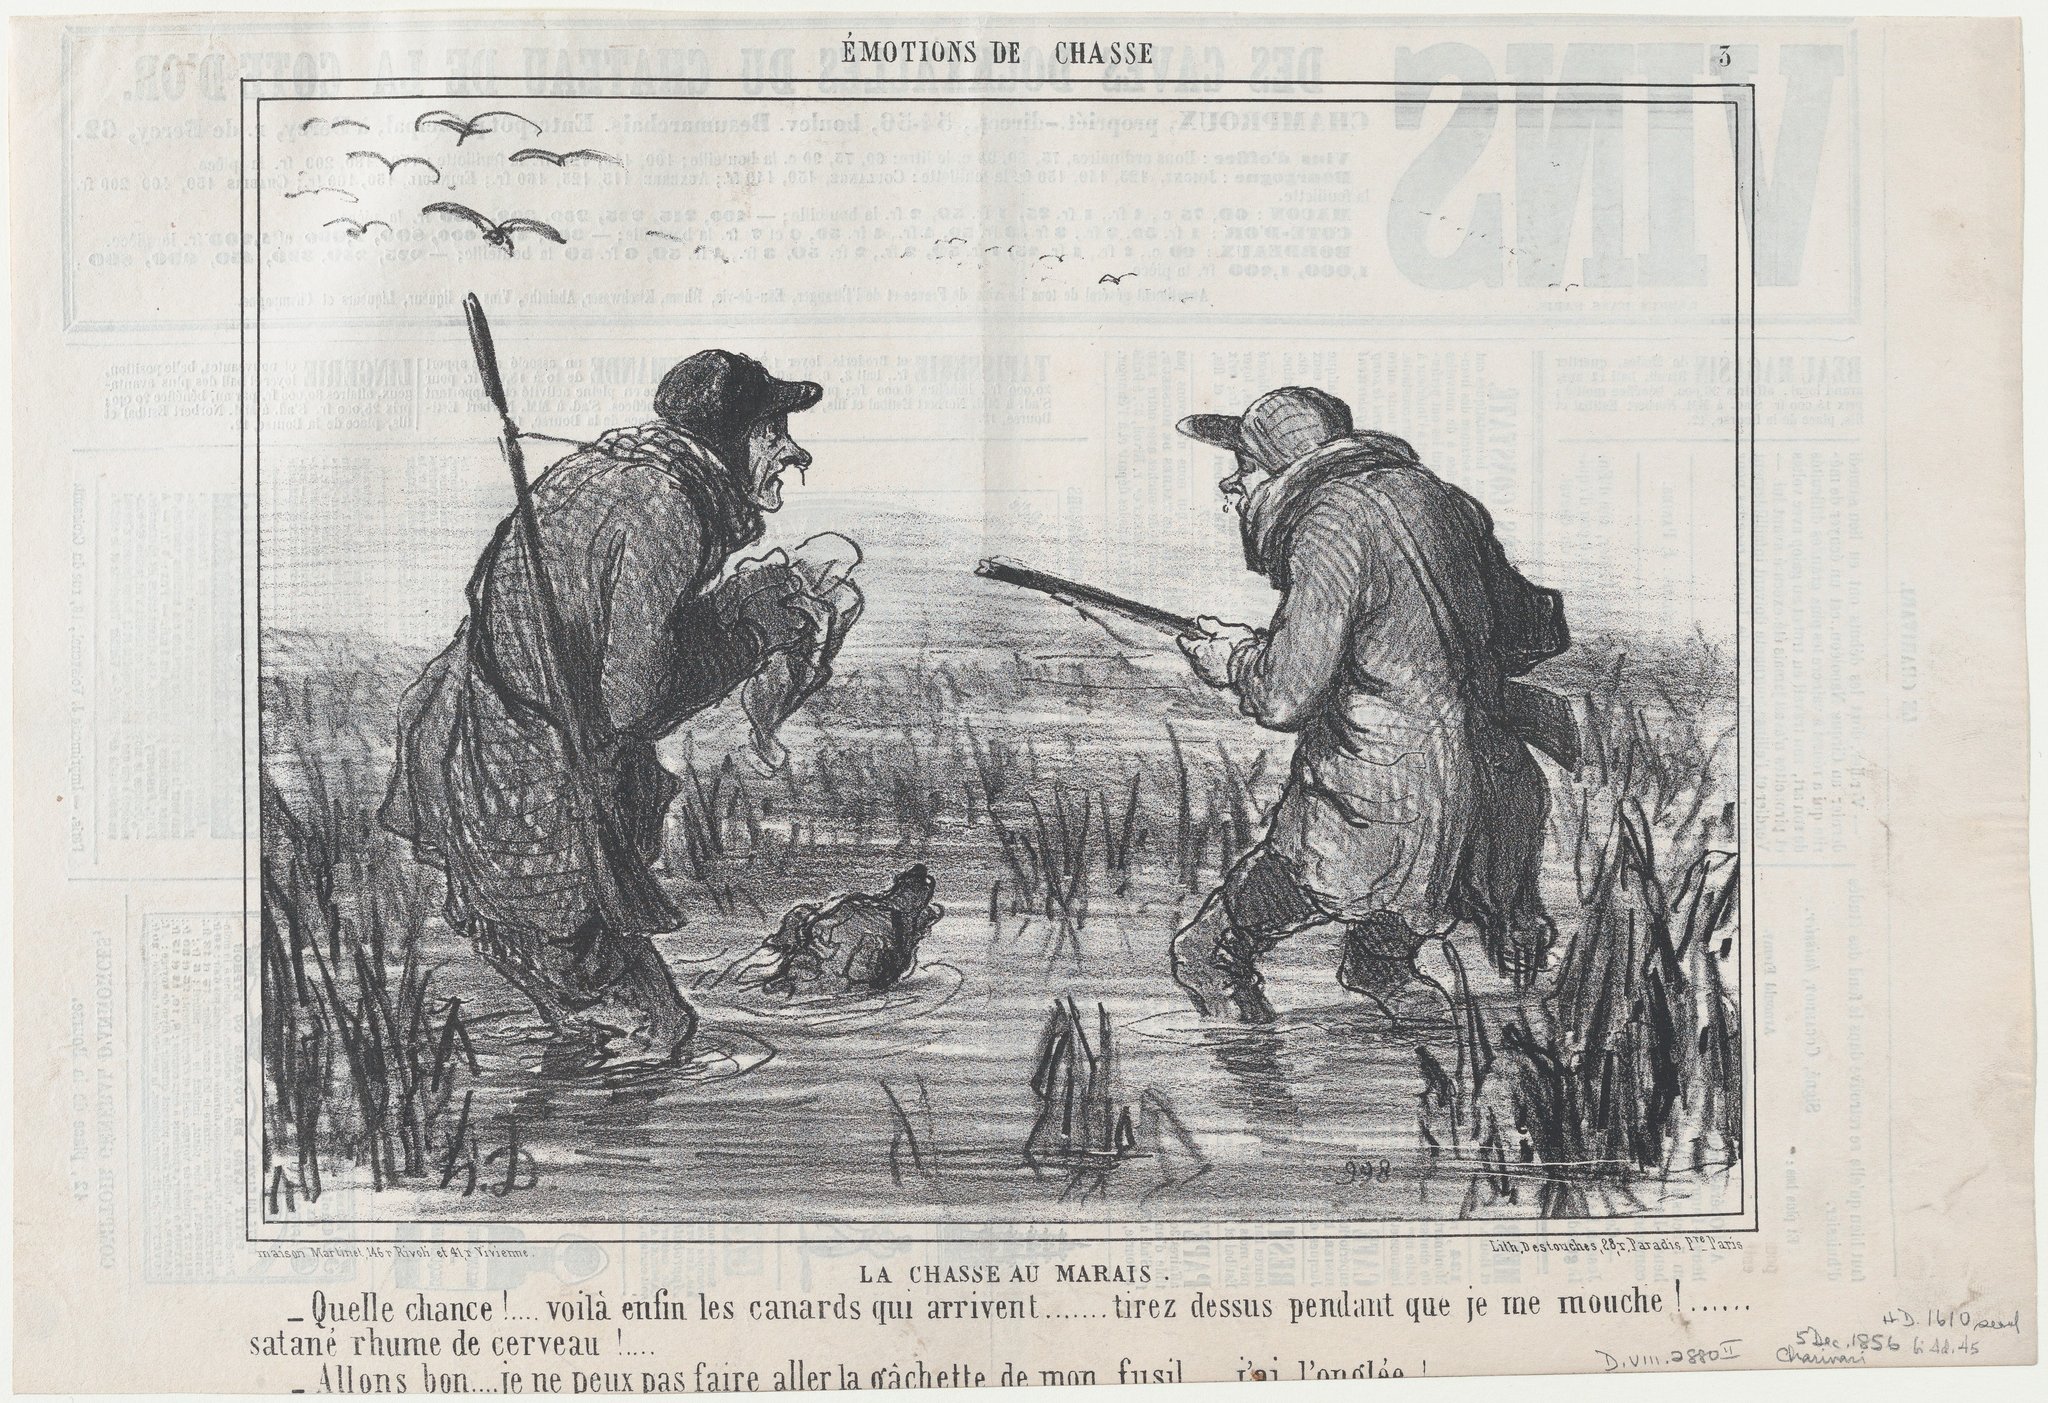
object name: print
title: Le Chasse au Marais –Quelle Chance!..., from Émotions de Chasse, published in Le Charivari, December 5, 1856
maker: honoré daumier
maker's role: artist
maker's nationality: french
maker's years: 1808-1879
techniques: lithograph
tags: animals,men,hunting